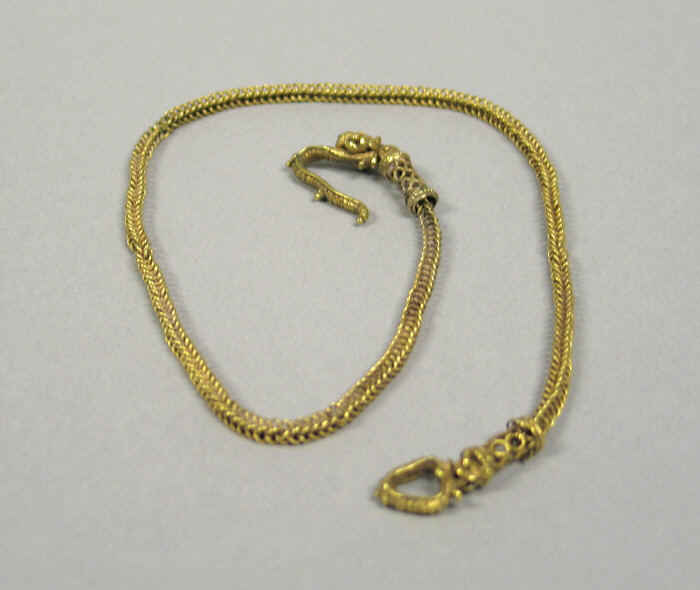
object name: chain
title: Braided Wire Chain with Clasp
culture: indonesian, javanese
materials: gold